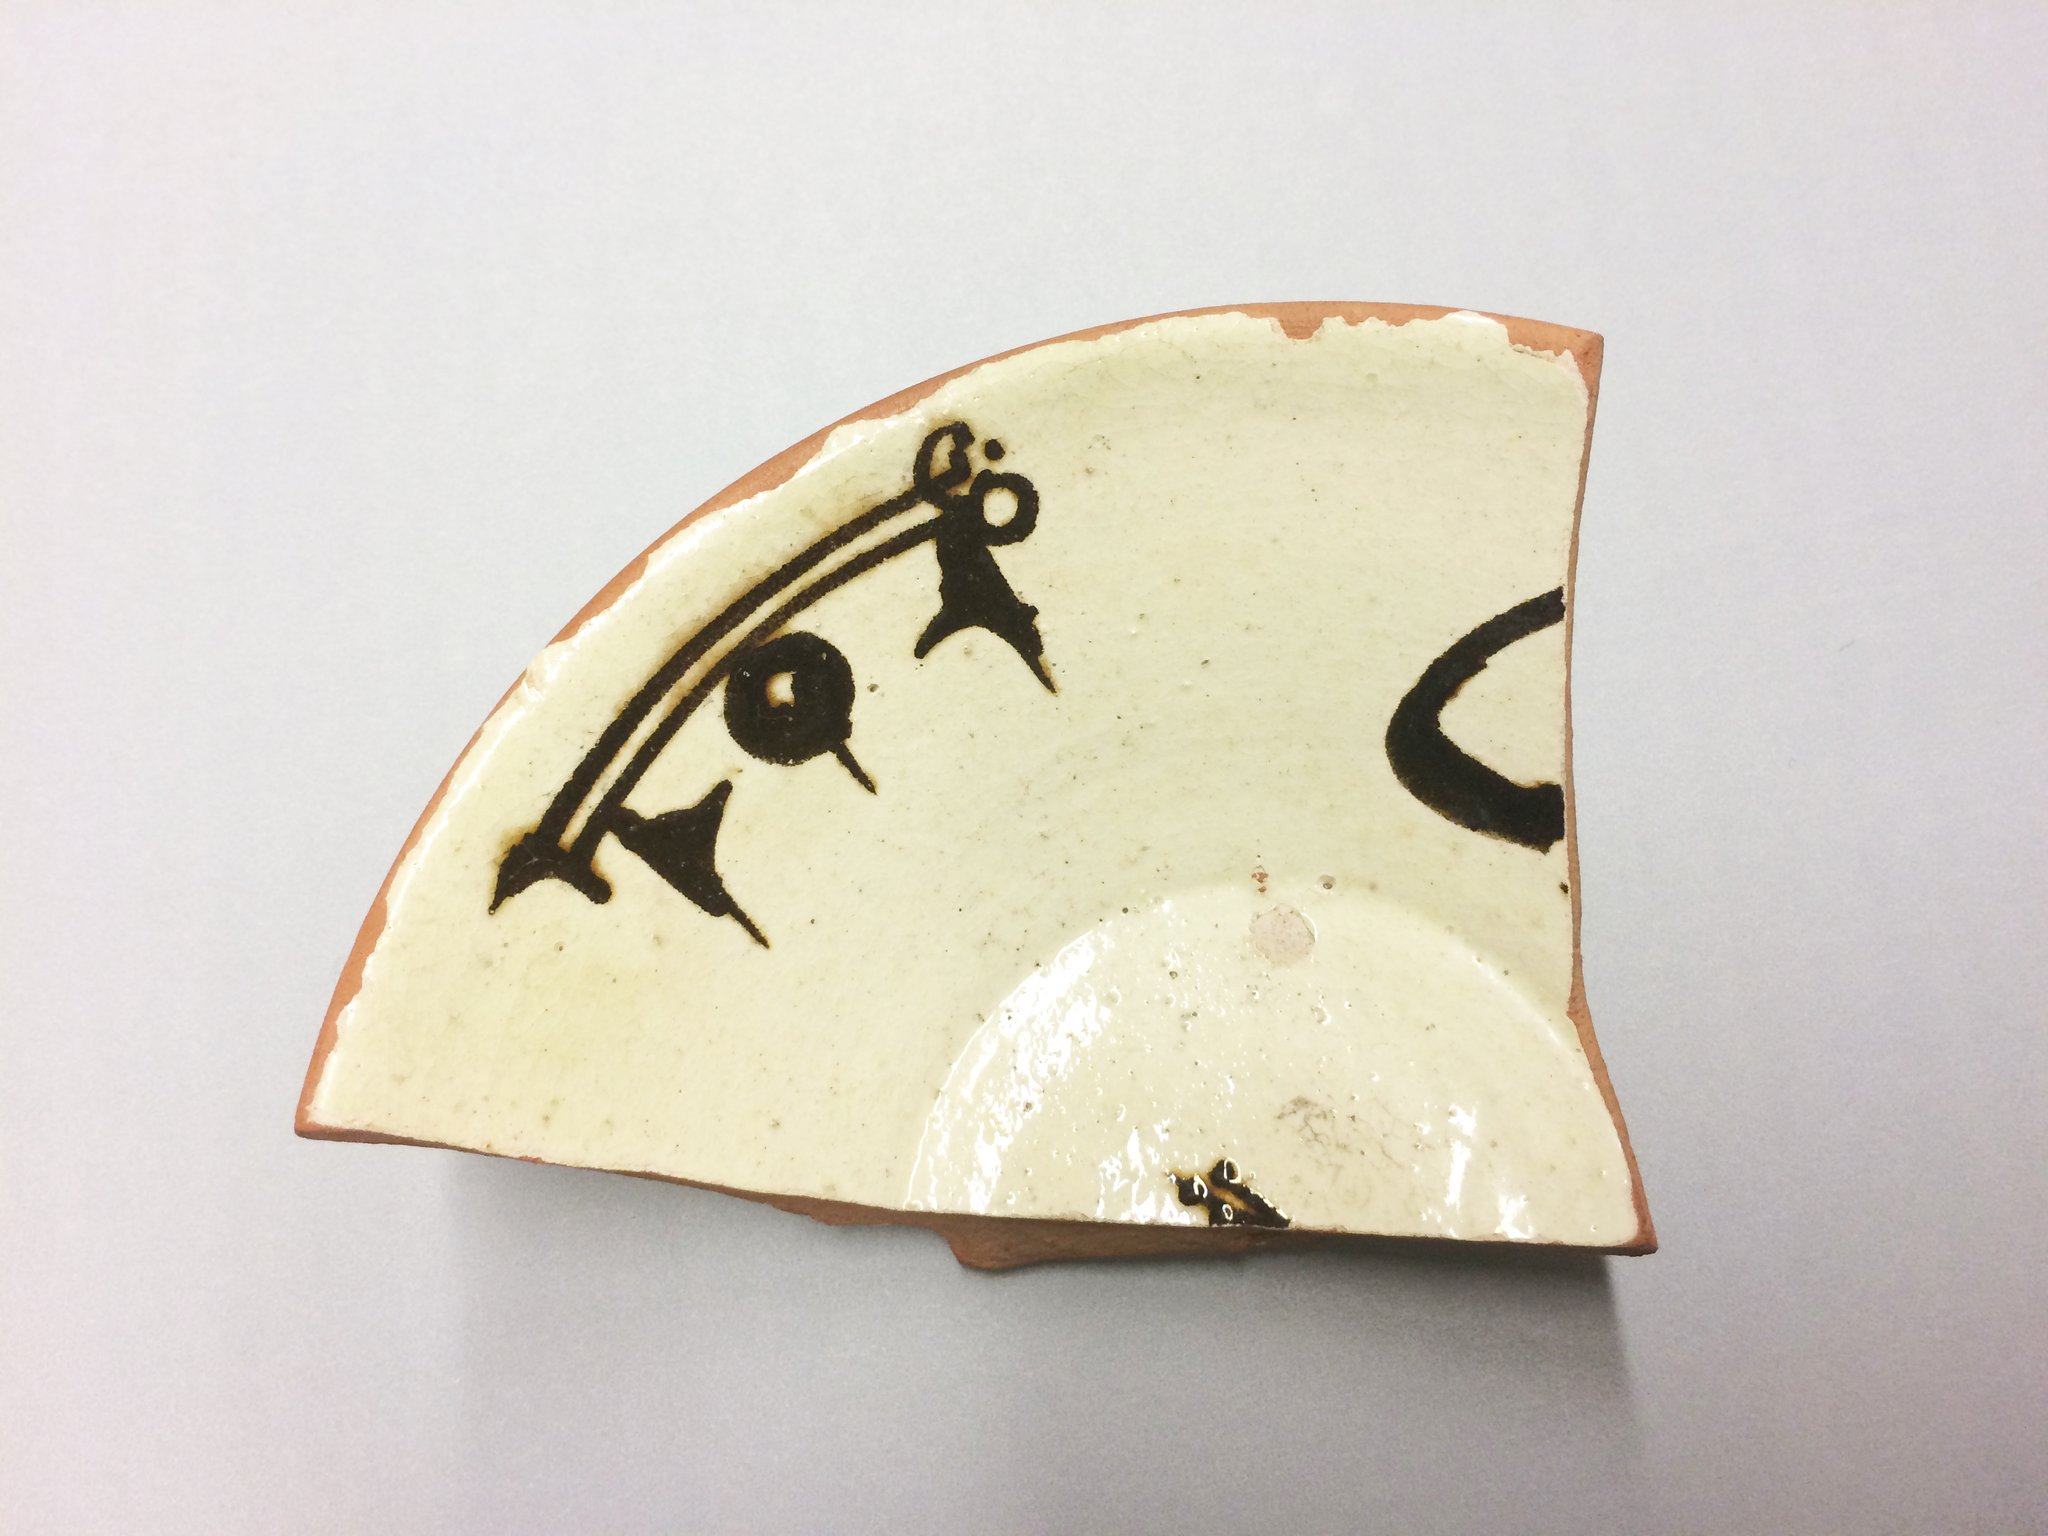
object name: fragment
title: Ceramic Fragment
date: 801-1000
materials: earthenware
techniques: glazing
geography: iran